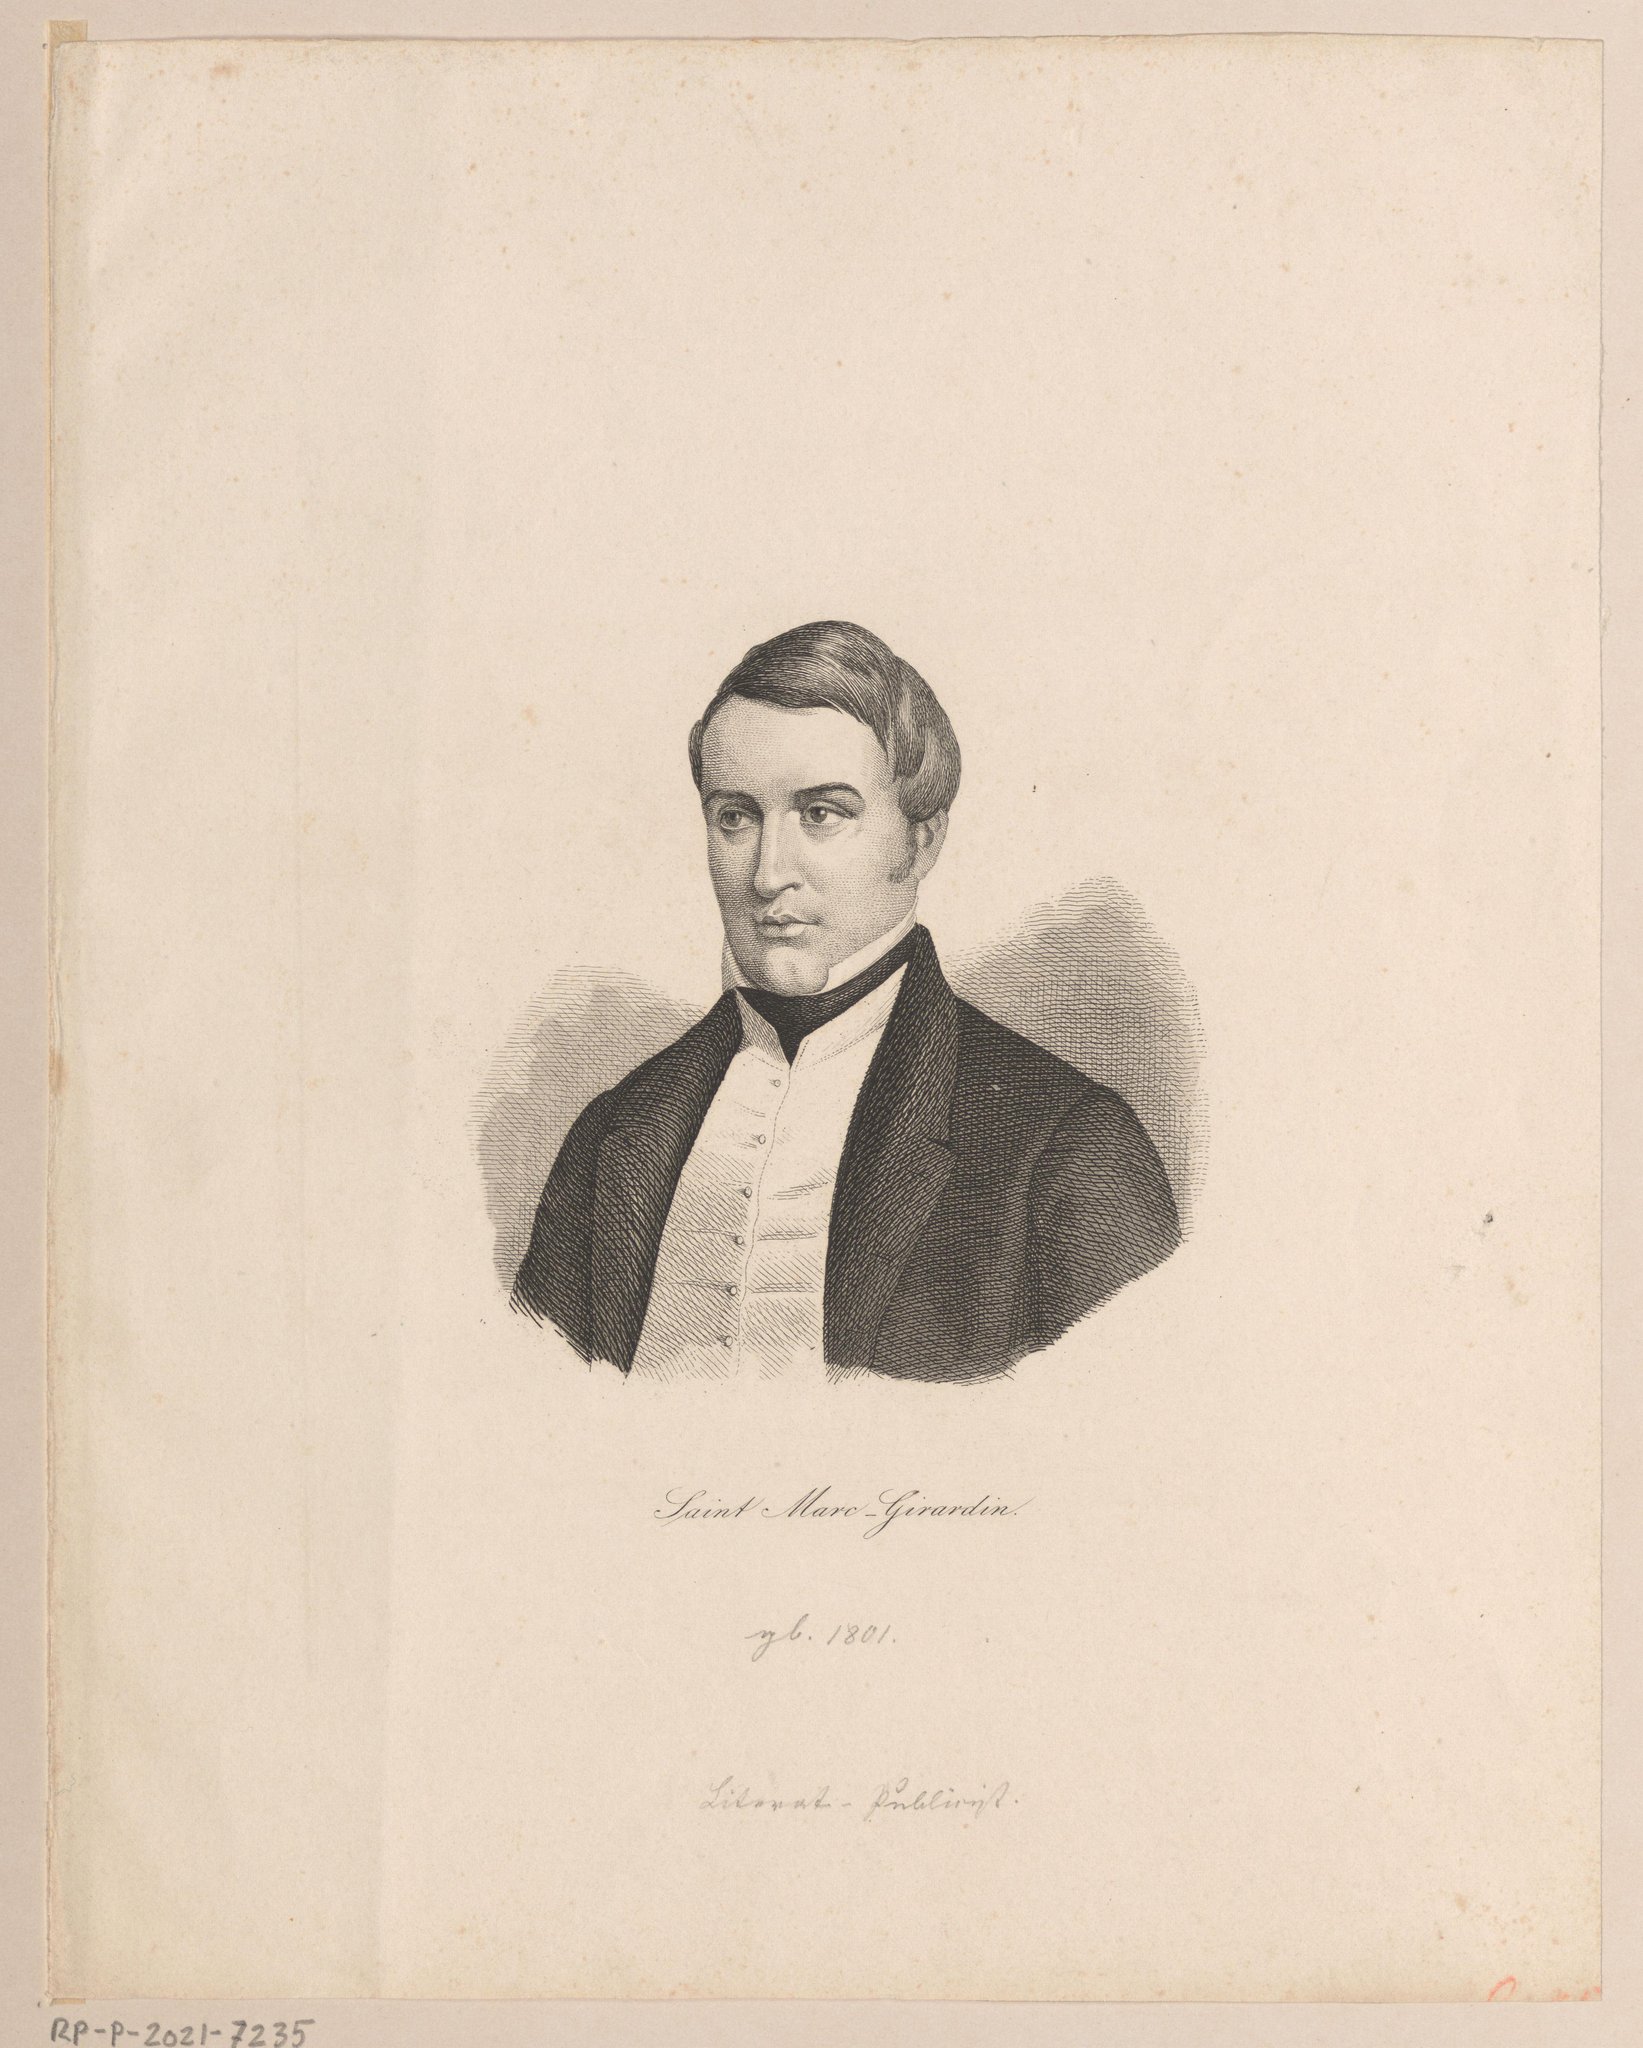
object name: print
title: Portret van Marc Girardin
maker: Anonymous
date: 1828-1899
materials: paper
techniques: engraving, etching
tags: politician, historical persons, politician, e.g. party leader